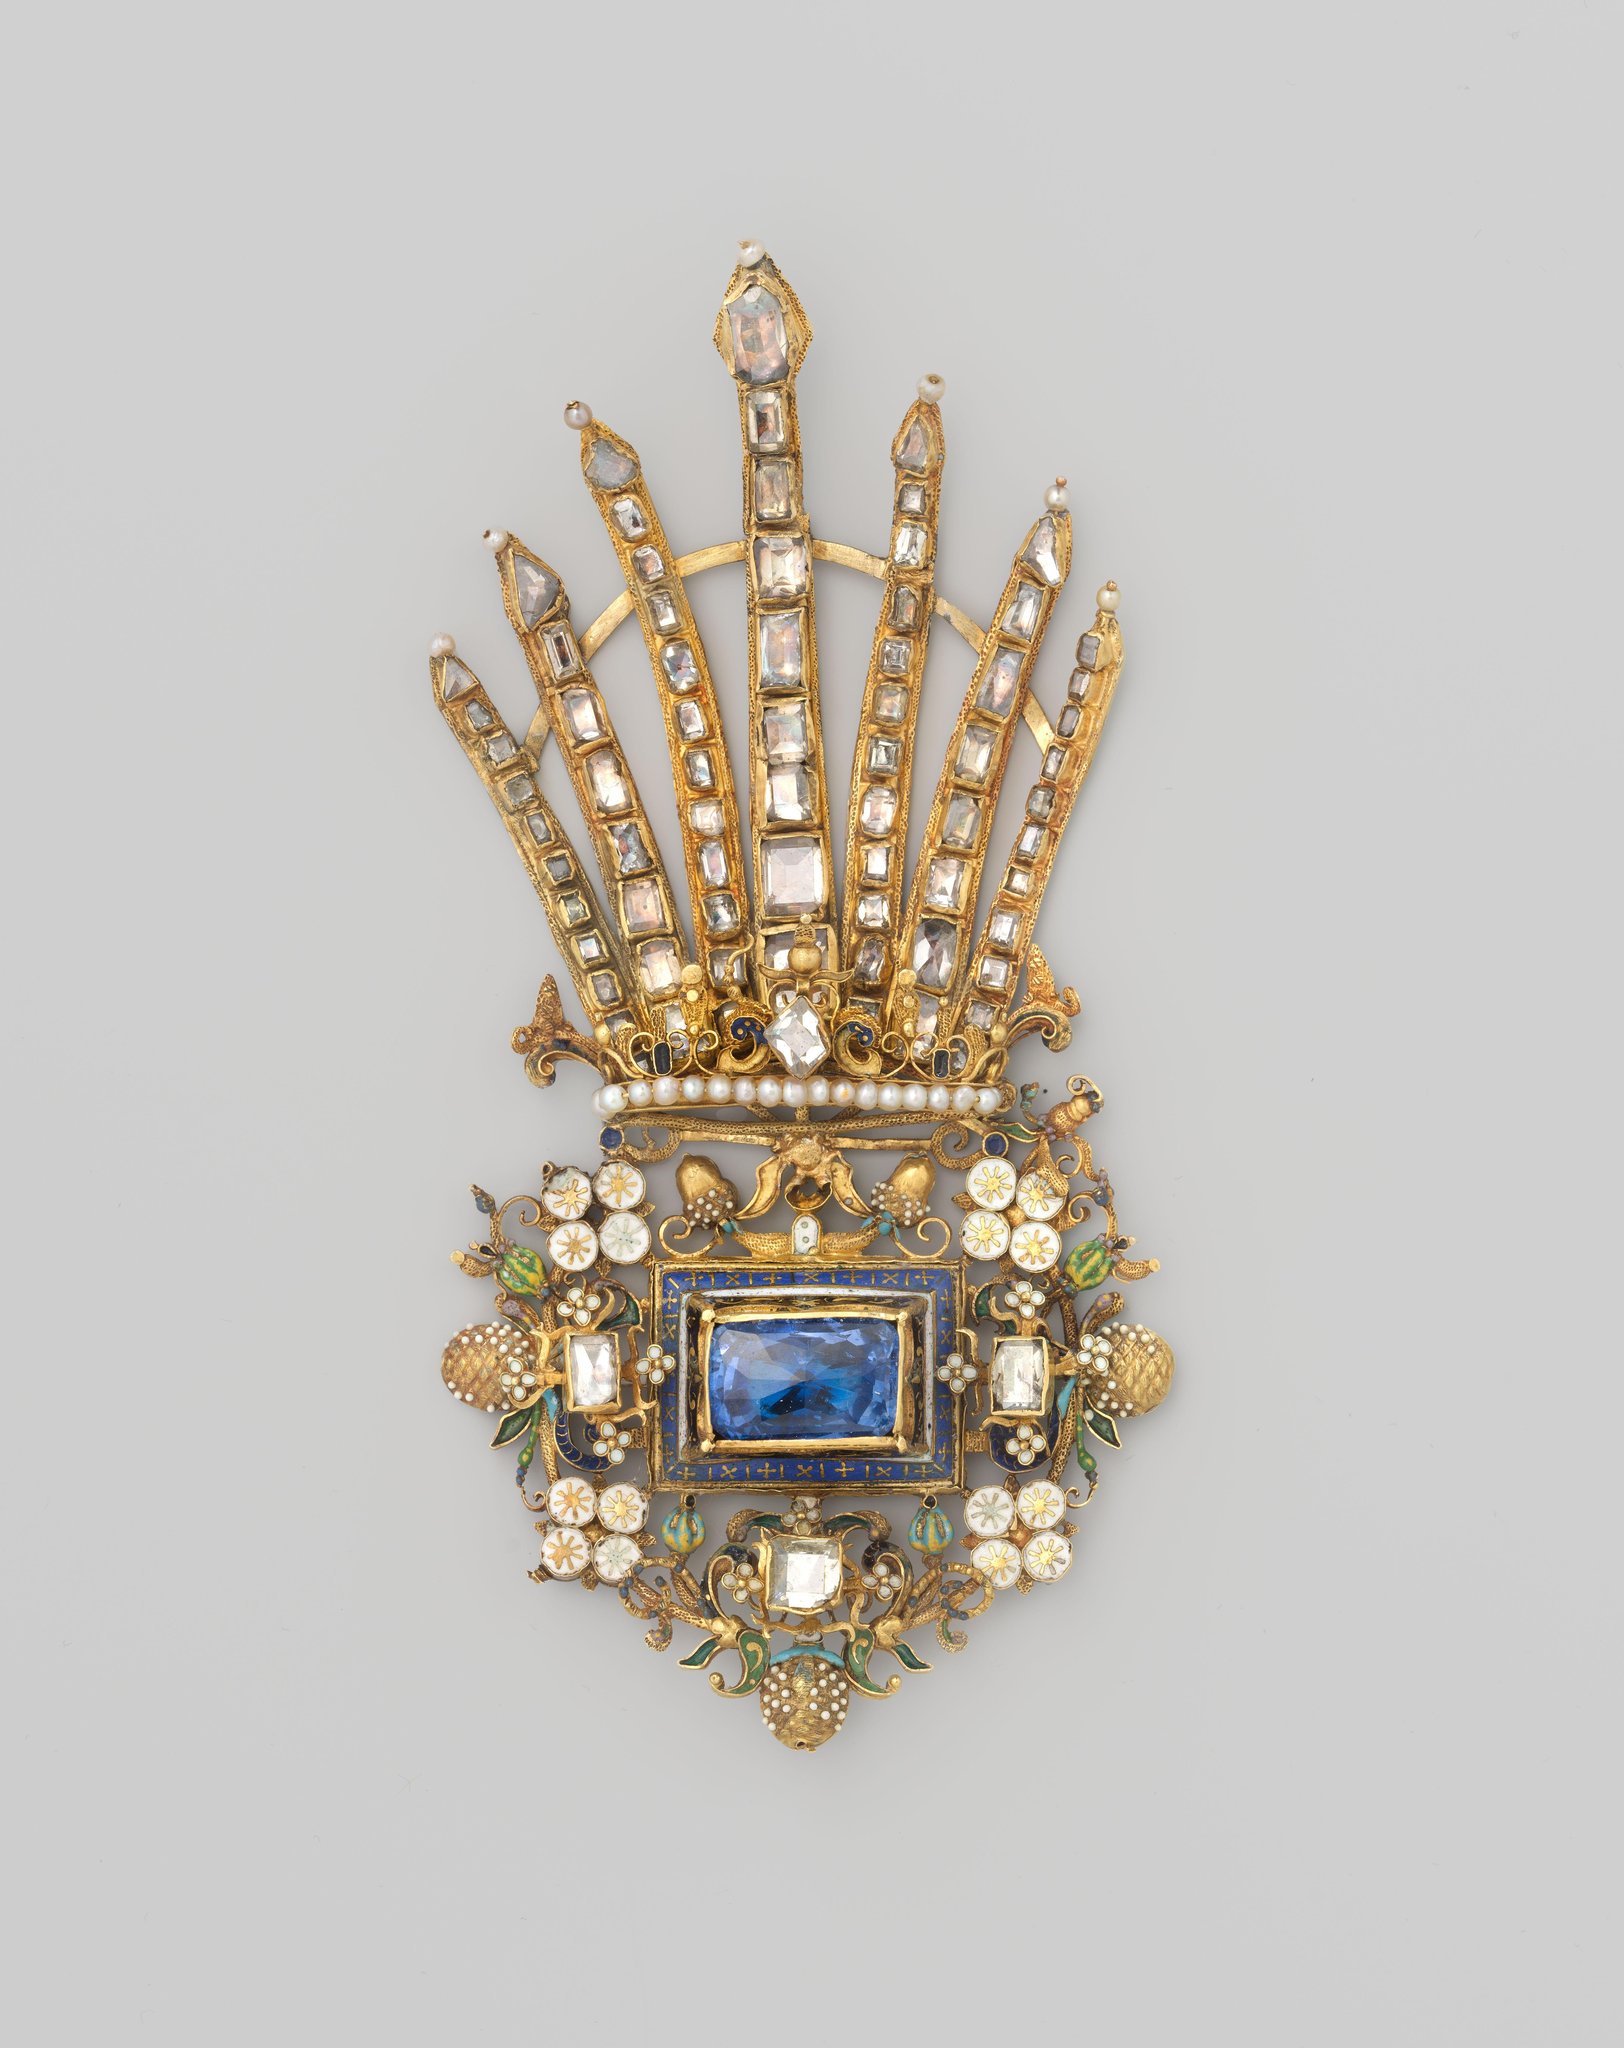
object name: aigrette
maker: Anonymous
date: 1600-1630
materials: diamond, feather, gold, pearl, silver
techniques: gilding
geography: europe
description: De aigrette bestaat uit een centraal medaillon, opgebouwd uit bloemen, bladeren en vruchten uitgevoerd in goud, diamant en parels, en geplaatst rond een grote saffier in een rechthoekige, taps toelopende zetkast. Het medaillon wordt bekroond door een smalle kroon met fleurons met daarachter zeven symmetrisch geordende veren, ieder met tafelgeslepen diamanten bezet. De keerzijde is geëmailleerd in symmetrische bloempatronen, op de veren en de uiteinden gecombineerd met paillons. Tegen de keerzijde is een haak in verguld zilver aangebracht, de helft van een klem waarmee het juweel aan de hoed kan worden vastgemaakt.